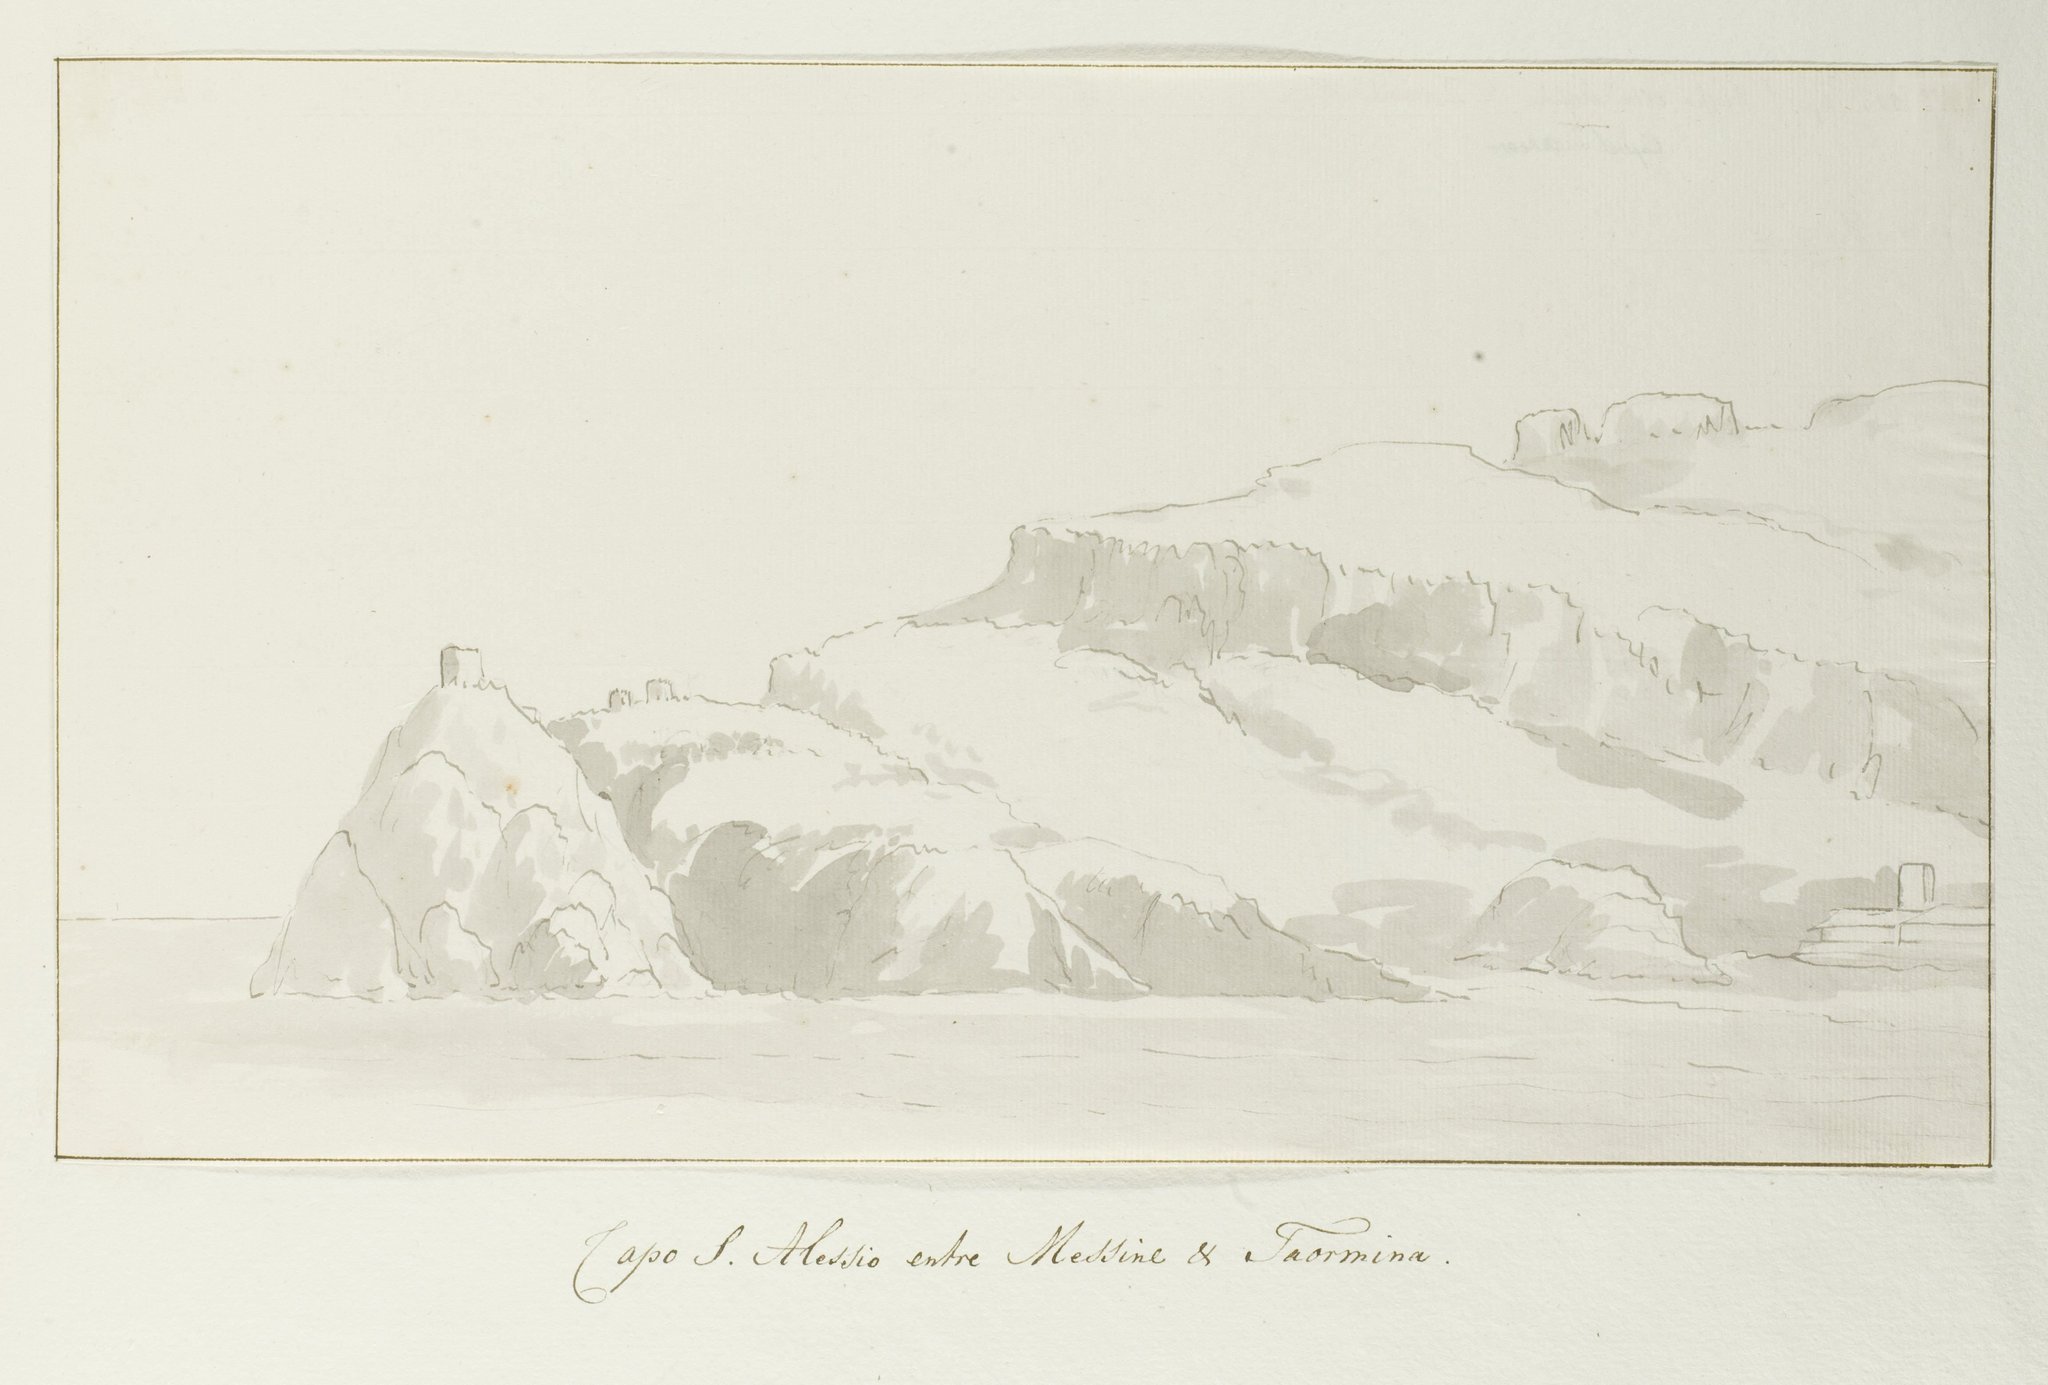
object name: drawing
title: Voyage en Italie, en Sicile et à Malte - 1778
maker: louis ducros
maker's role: draughtsman, print maker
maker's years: 1748-1810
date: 1778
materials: chalk, paper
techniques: brush, pen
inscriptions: number: ‘No 150 Capo S. Alessio entre Messine & Taormina’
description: Tekening uit het album 'Voyage en Italie, en Sicile et à Malte', 1778.